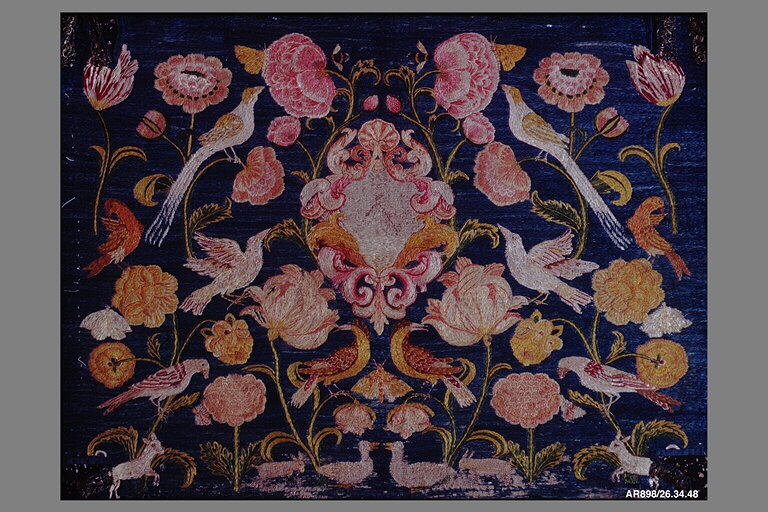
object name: cover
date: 1701-1800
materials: linen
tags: animals,birds,flowers